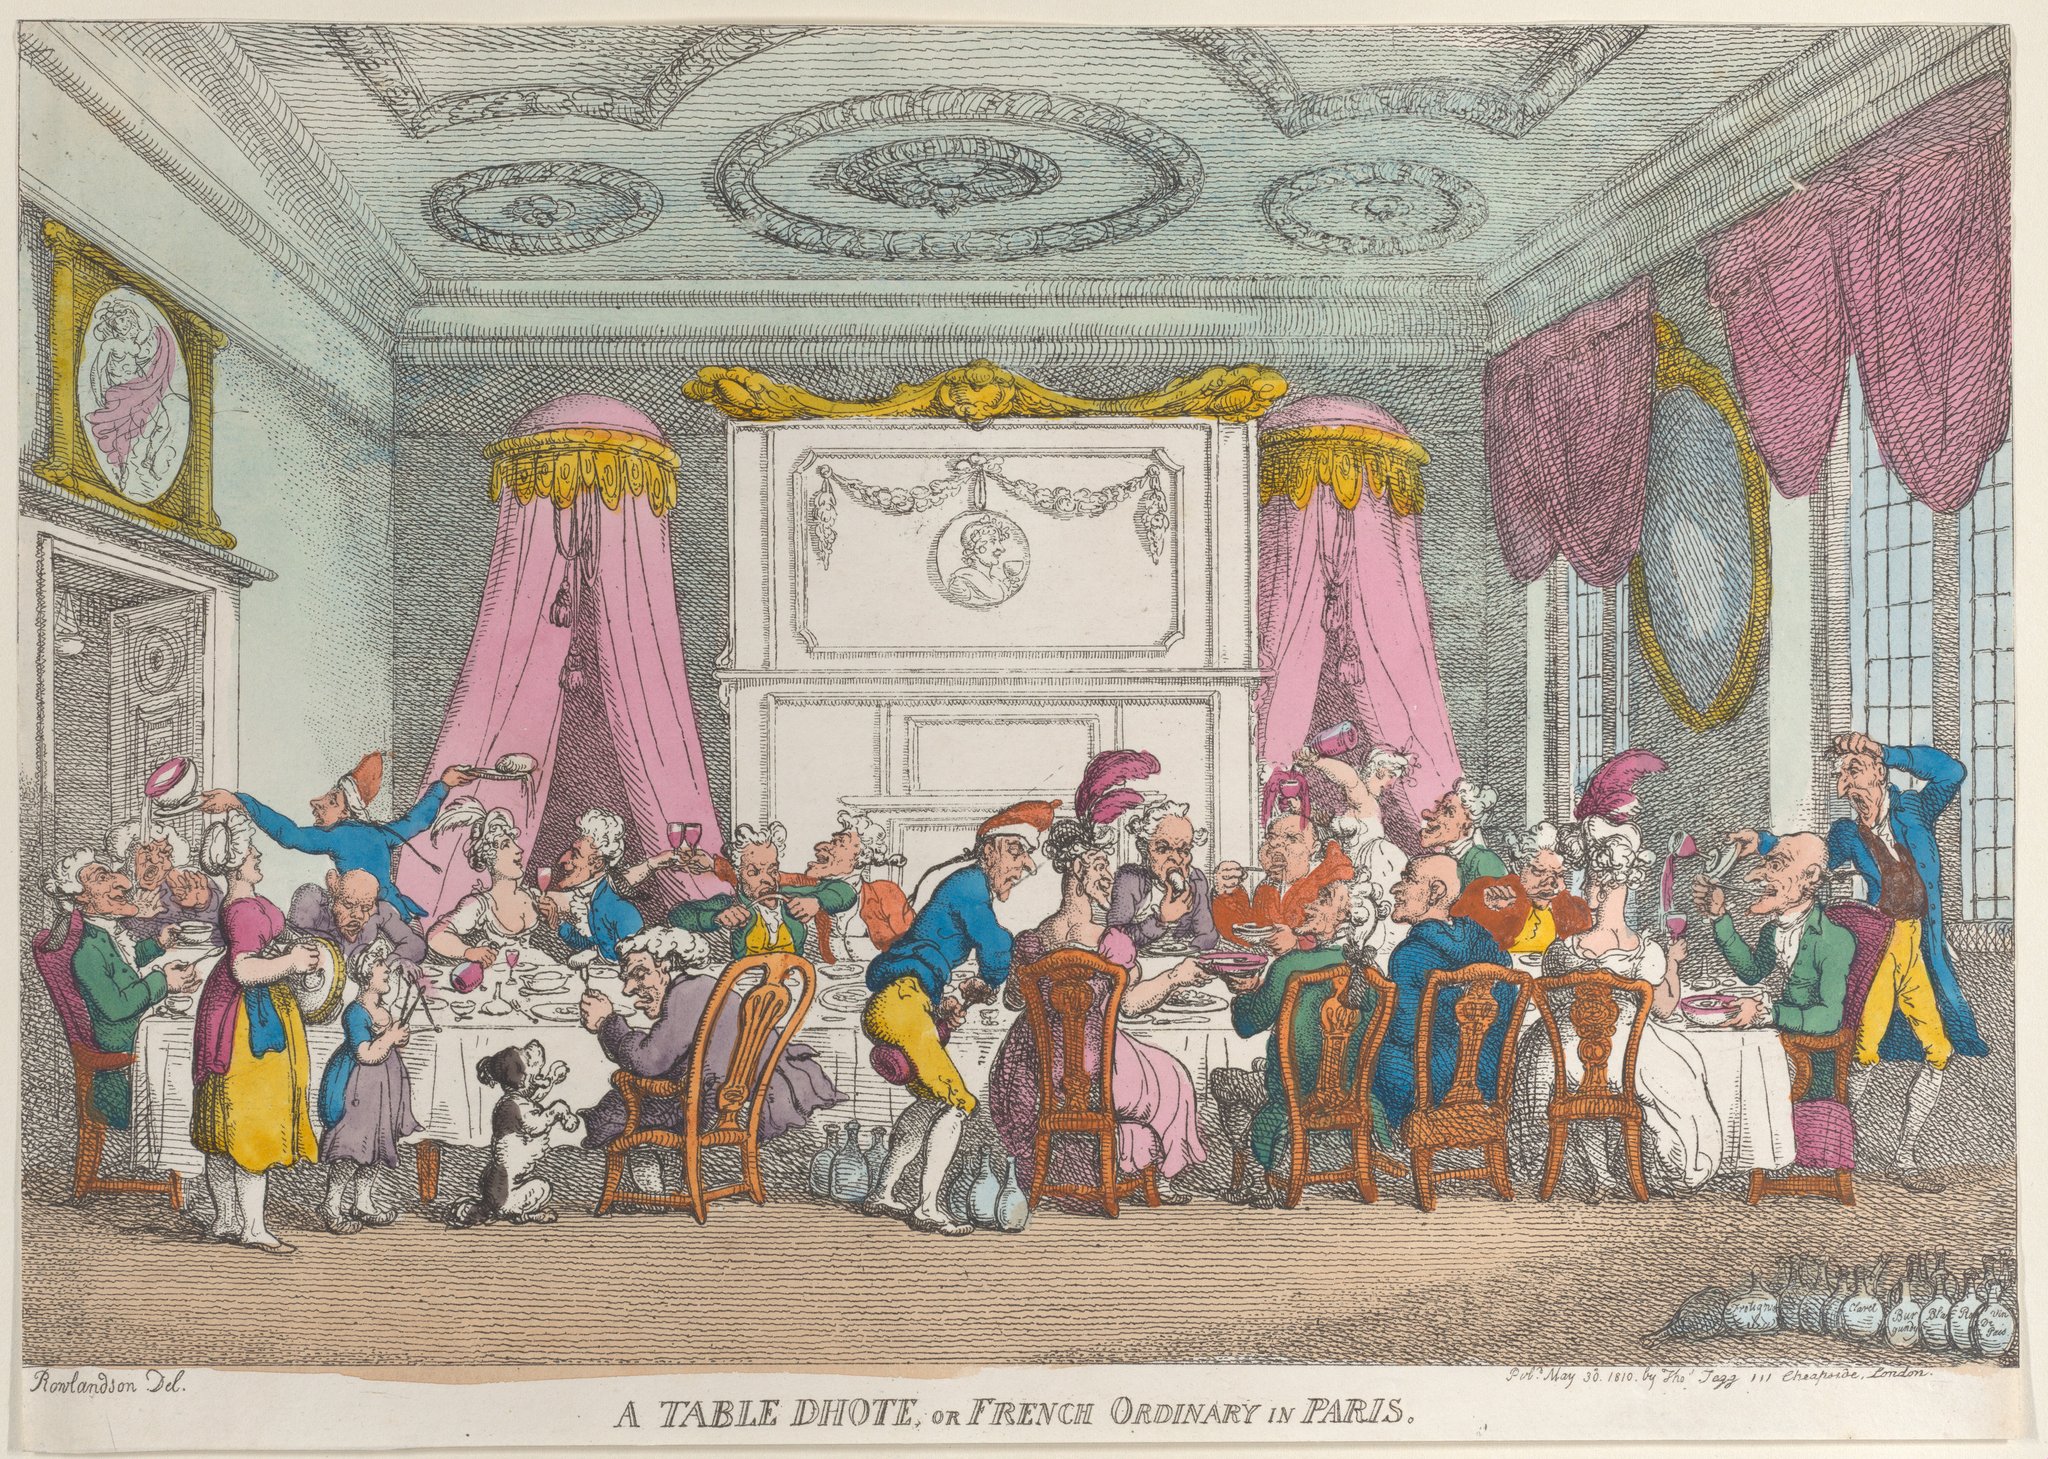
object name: print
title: A Table D'Hote or French Ordinary in Paris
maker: thomas rowlandson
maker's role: artist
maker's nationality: british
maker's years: 1757-1827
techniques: etching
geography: london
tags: satire,men,women,dogs,dining